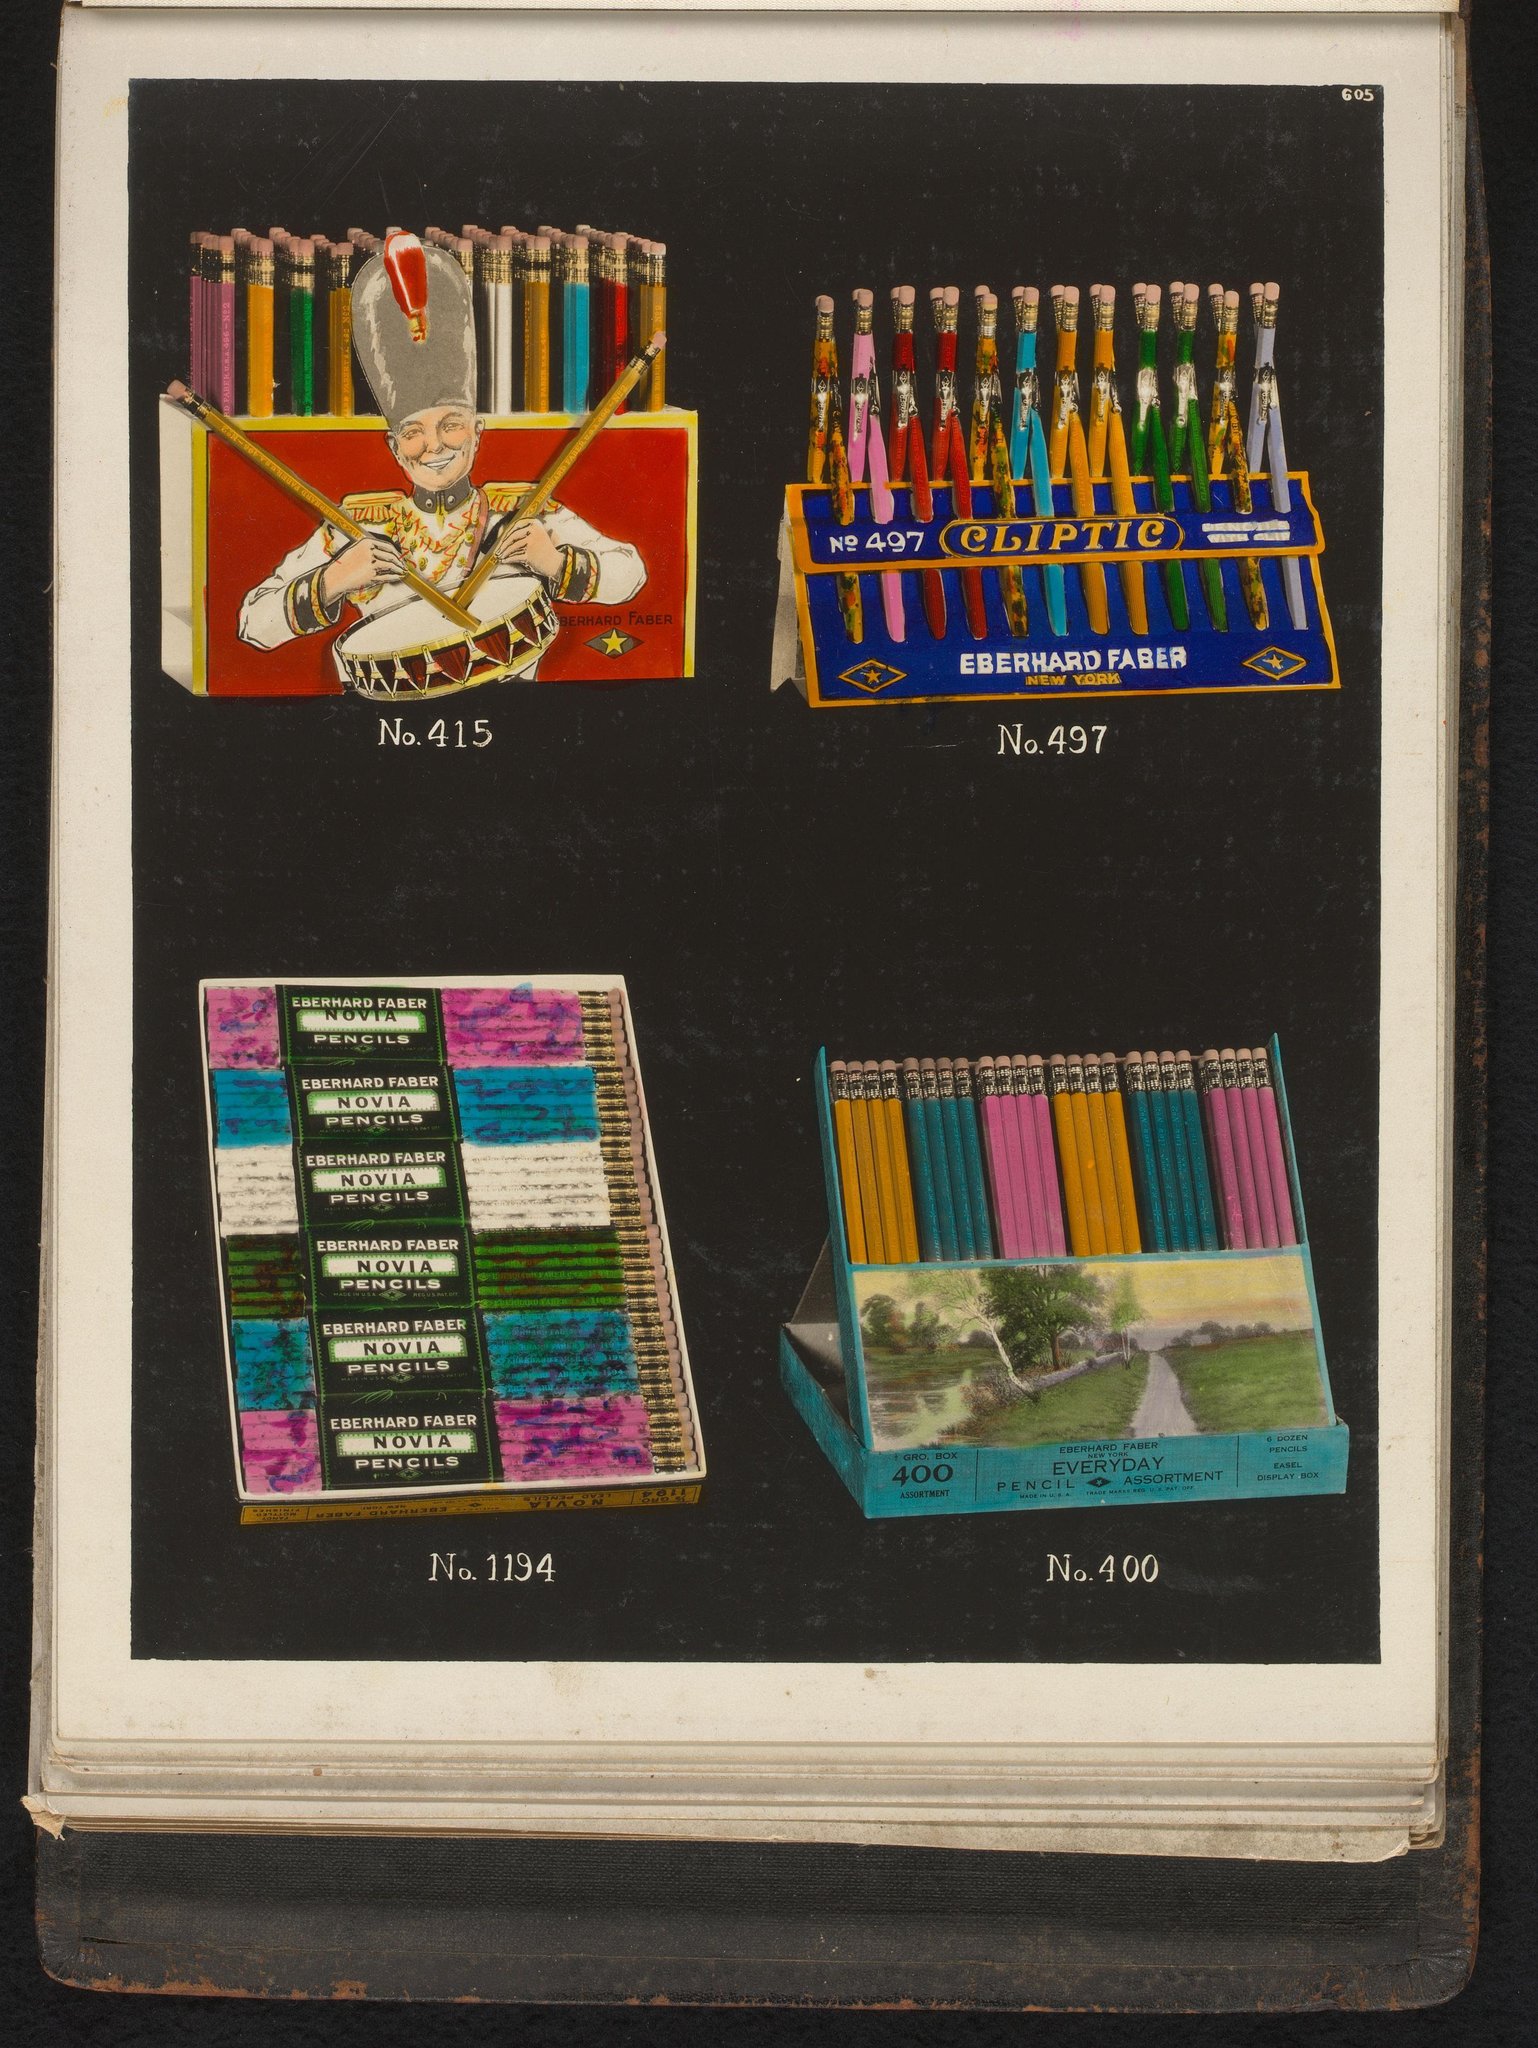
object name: photograph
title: Standaarden met potloden van Eberhard Faber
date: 1915-1935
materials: paper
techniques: gelatin silver print, hand coloring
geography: springfield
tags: pencil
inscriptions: stamp: ‘Paramount/ Commercial Studios/ 145 Chestnut St./ Springfield - Mass.’, number: ‘605’